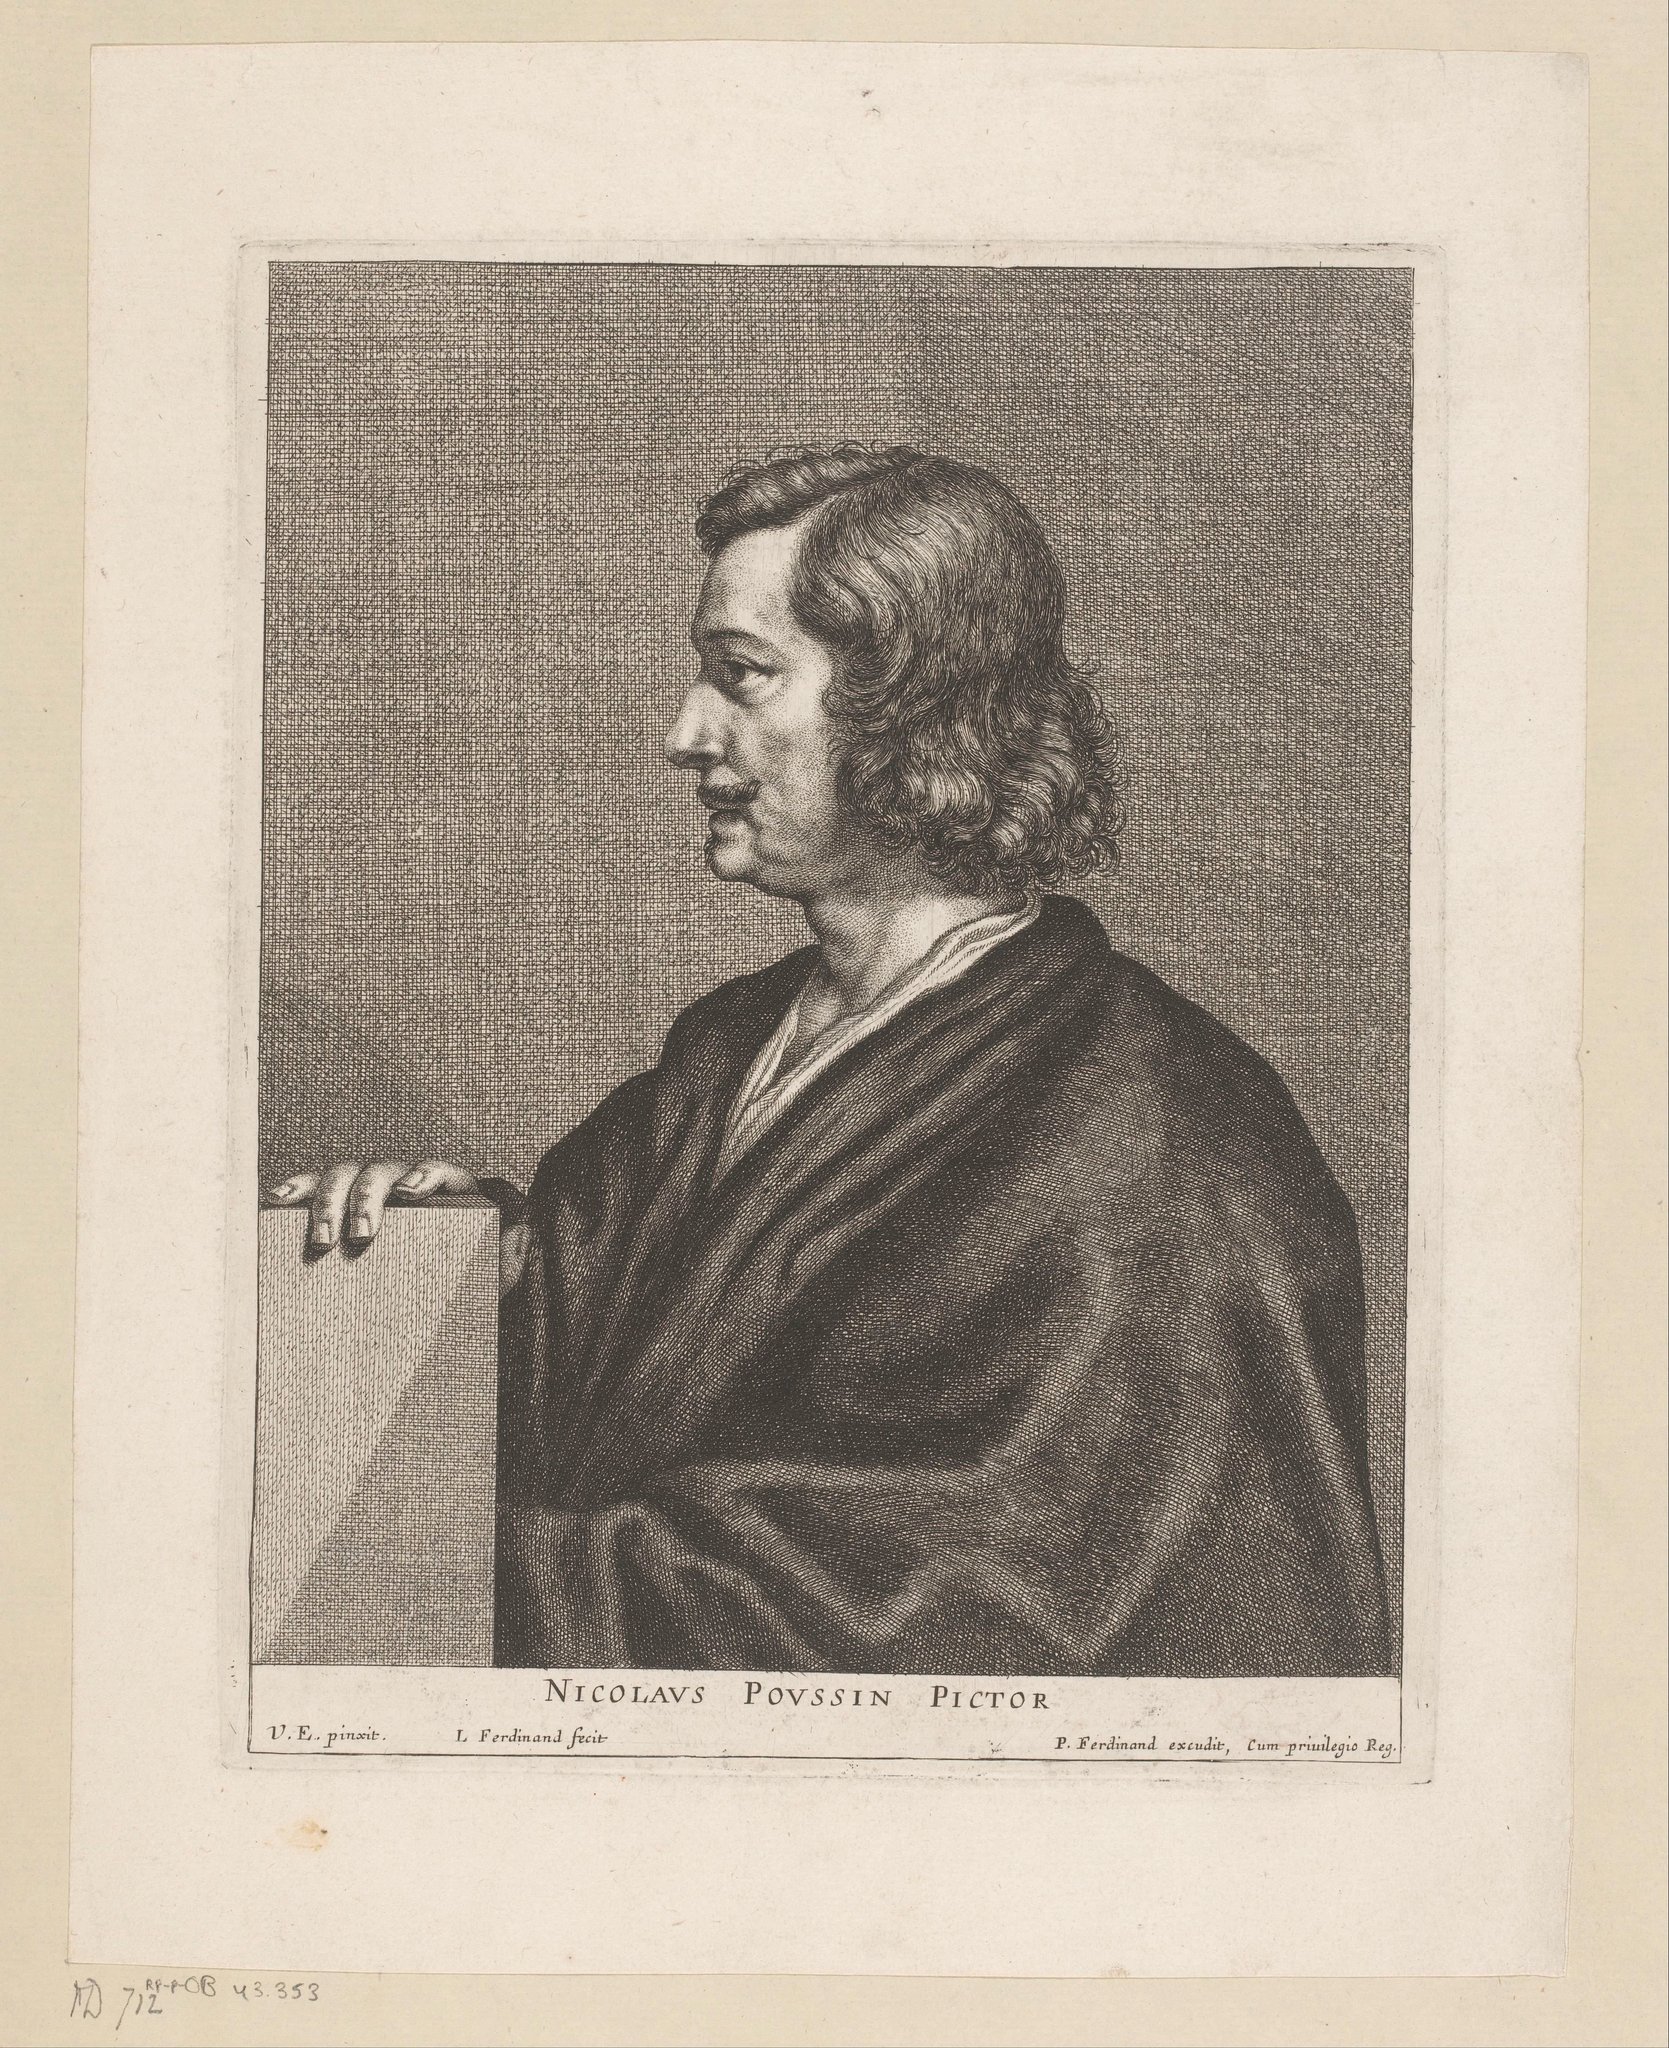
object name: print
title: Portret van Nicolas Poussin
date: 1627-1689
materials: paper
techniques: engraving, etching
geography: france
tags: painter, draughtsman, nicolas poussin, portrait, self-portrait of painter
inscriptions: collector's mark: Lugt 240